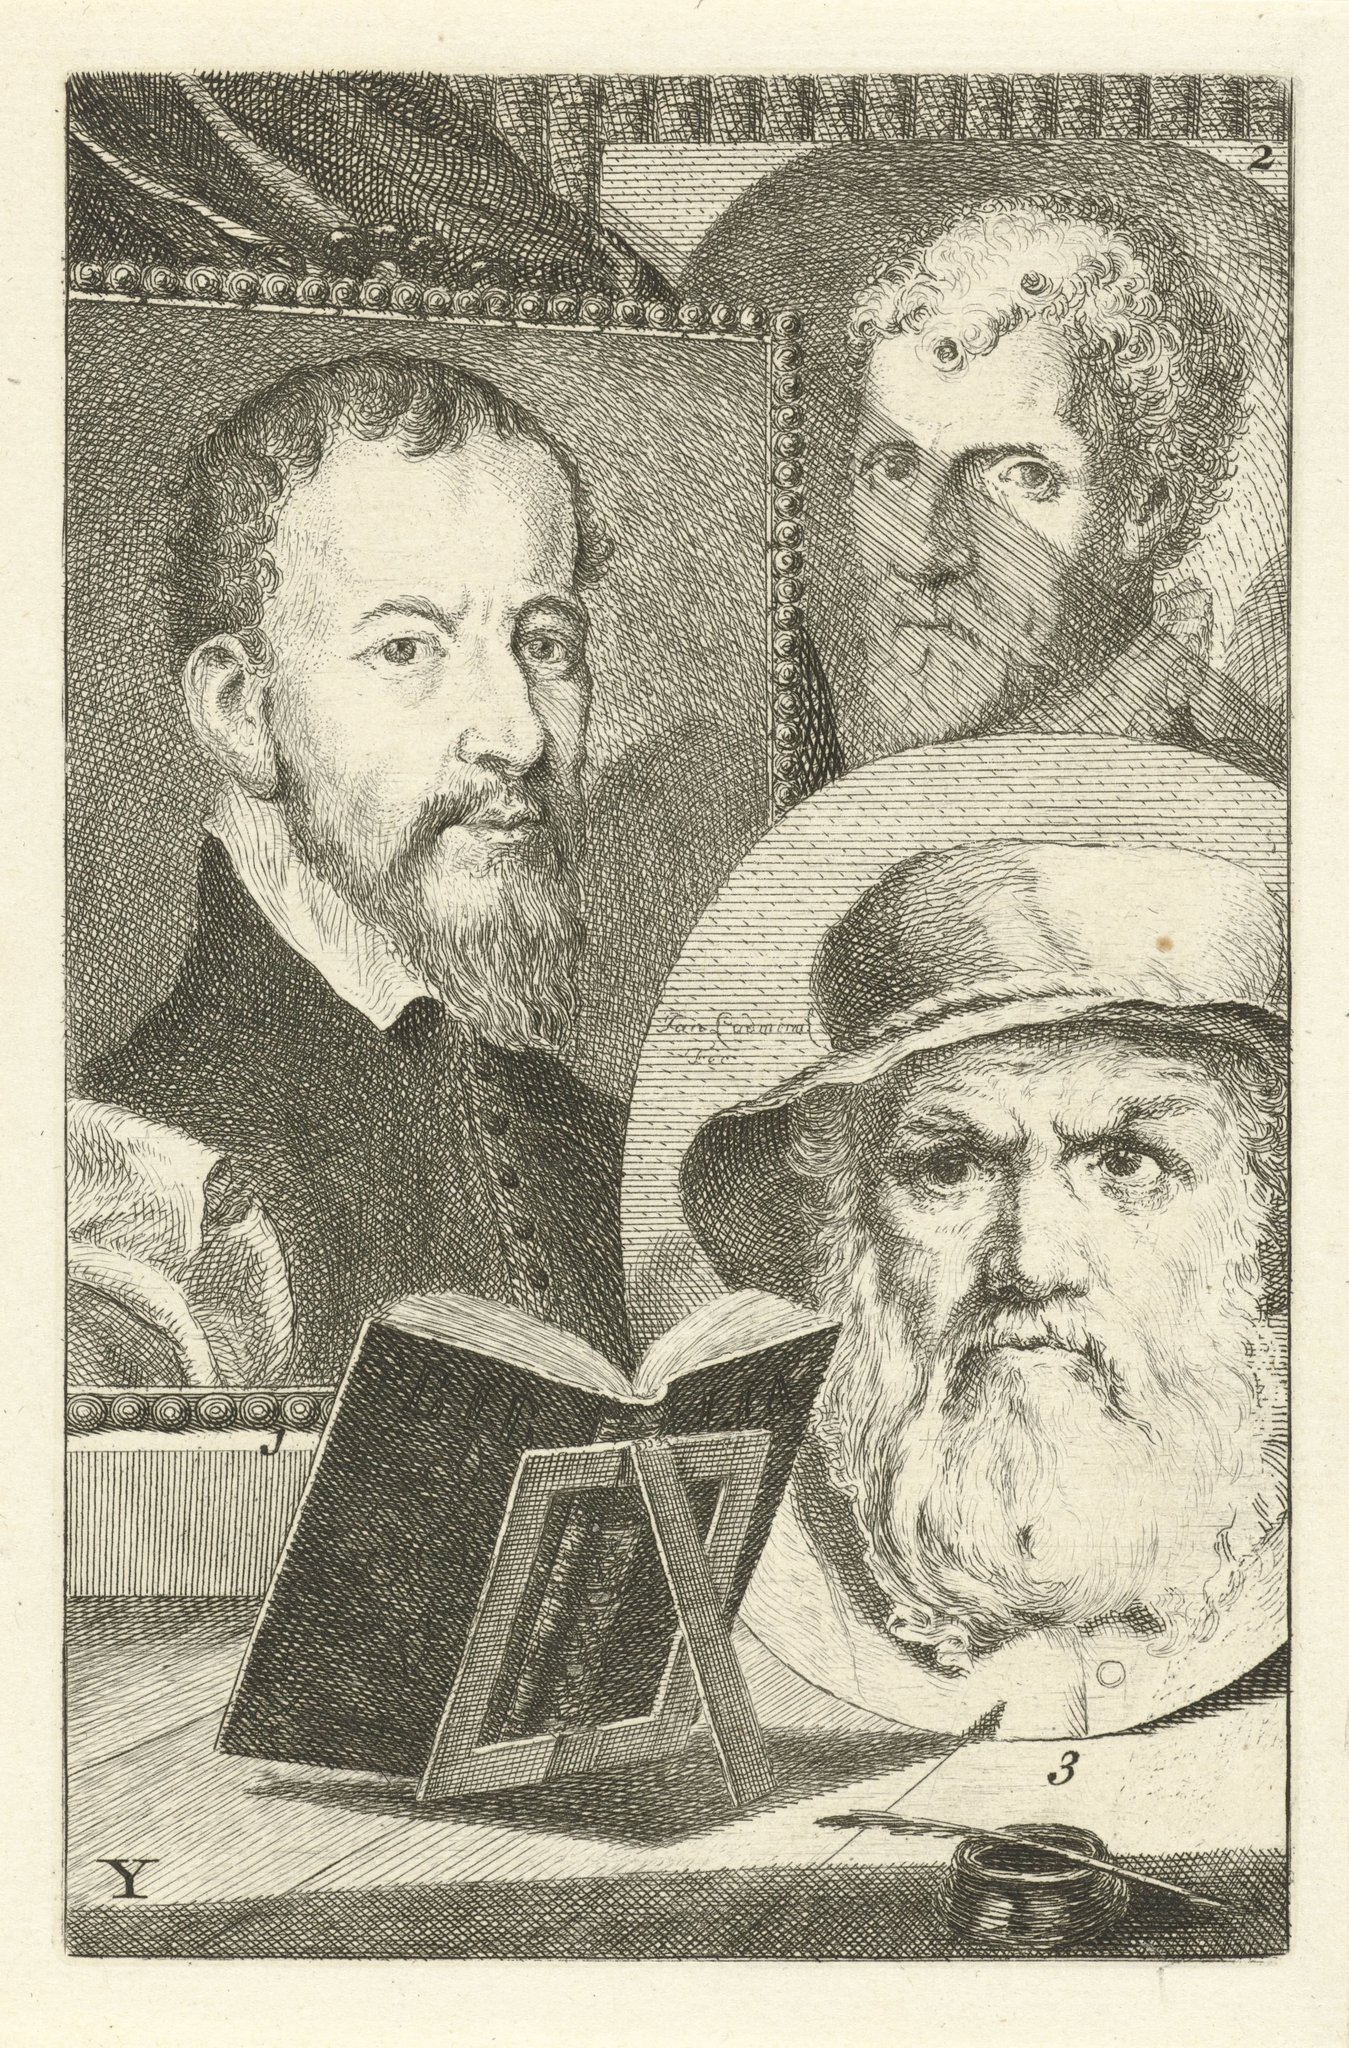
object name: print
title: Portretten van Josse van Liere, Cornelis Cort en Dirck Volckertsz. Coornhert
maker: jan l admiral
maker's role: draughtsman, print maker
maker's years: 1699-1773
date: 1764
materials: paper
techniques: etching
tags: brussels, painter, josse van liere, cornelis cort, amsterdam, gouda, print maker, draughtsman, dirck volckertsz. coornhert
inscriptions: collector's mark: Lugt 2228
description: Prent opgenomen in: Mander, Karel van; Jongh, Jacobus de (vert.). Het leven der doorluchtige Nederlandsche en eenige Hoogduitsche schilders. Amsterdam: Steven van Esveldt, 1764.